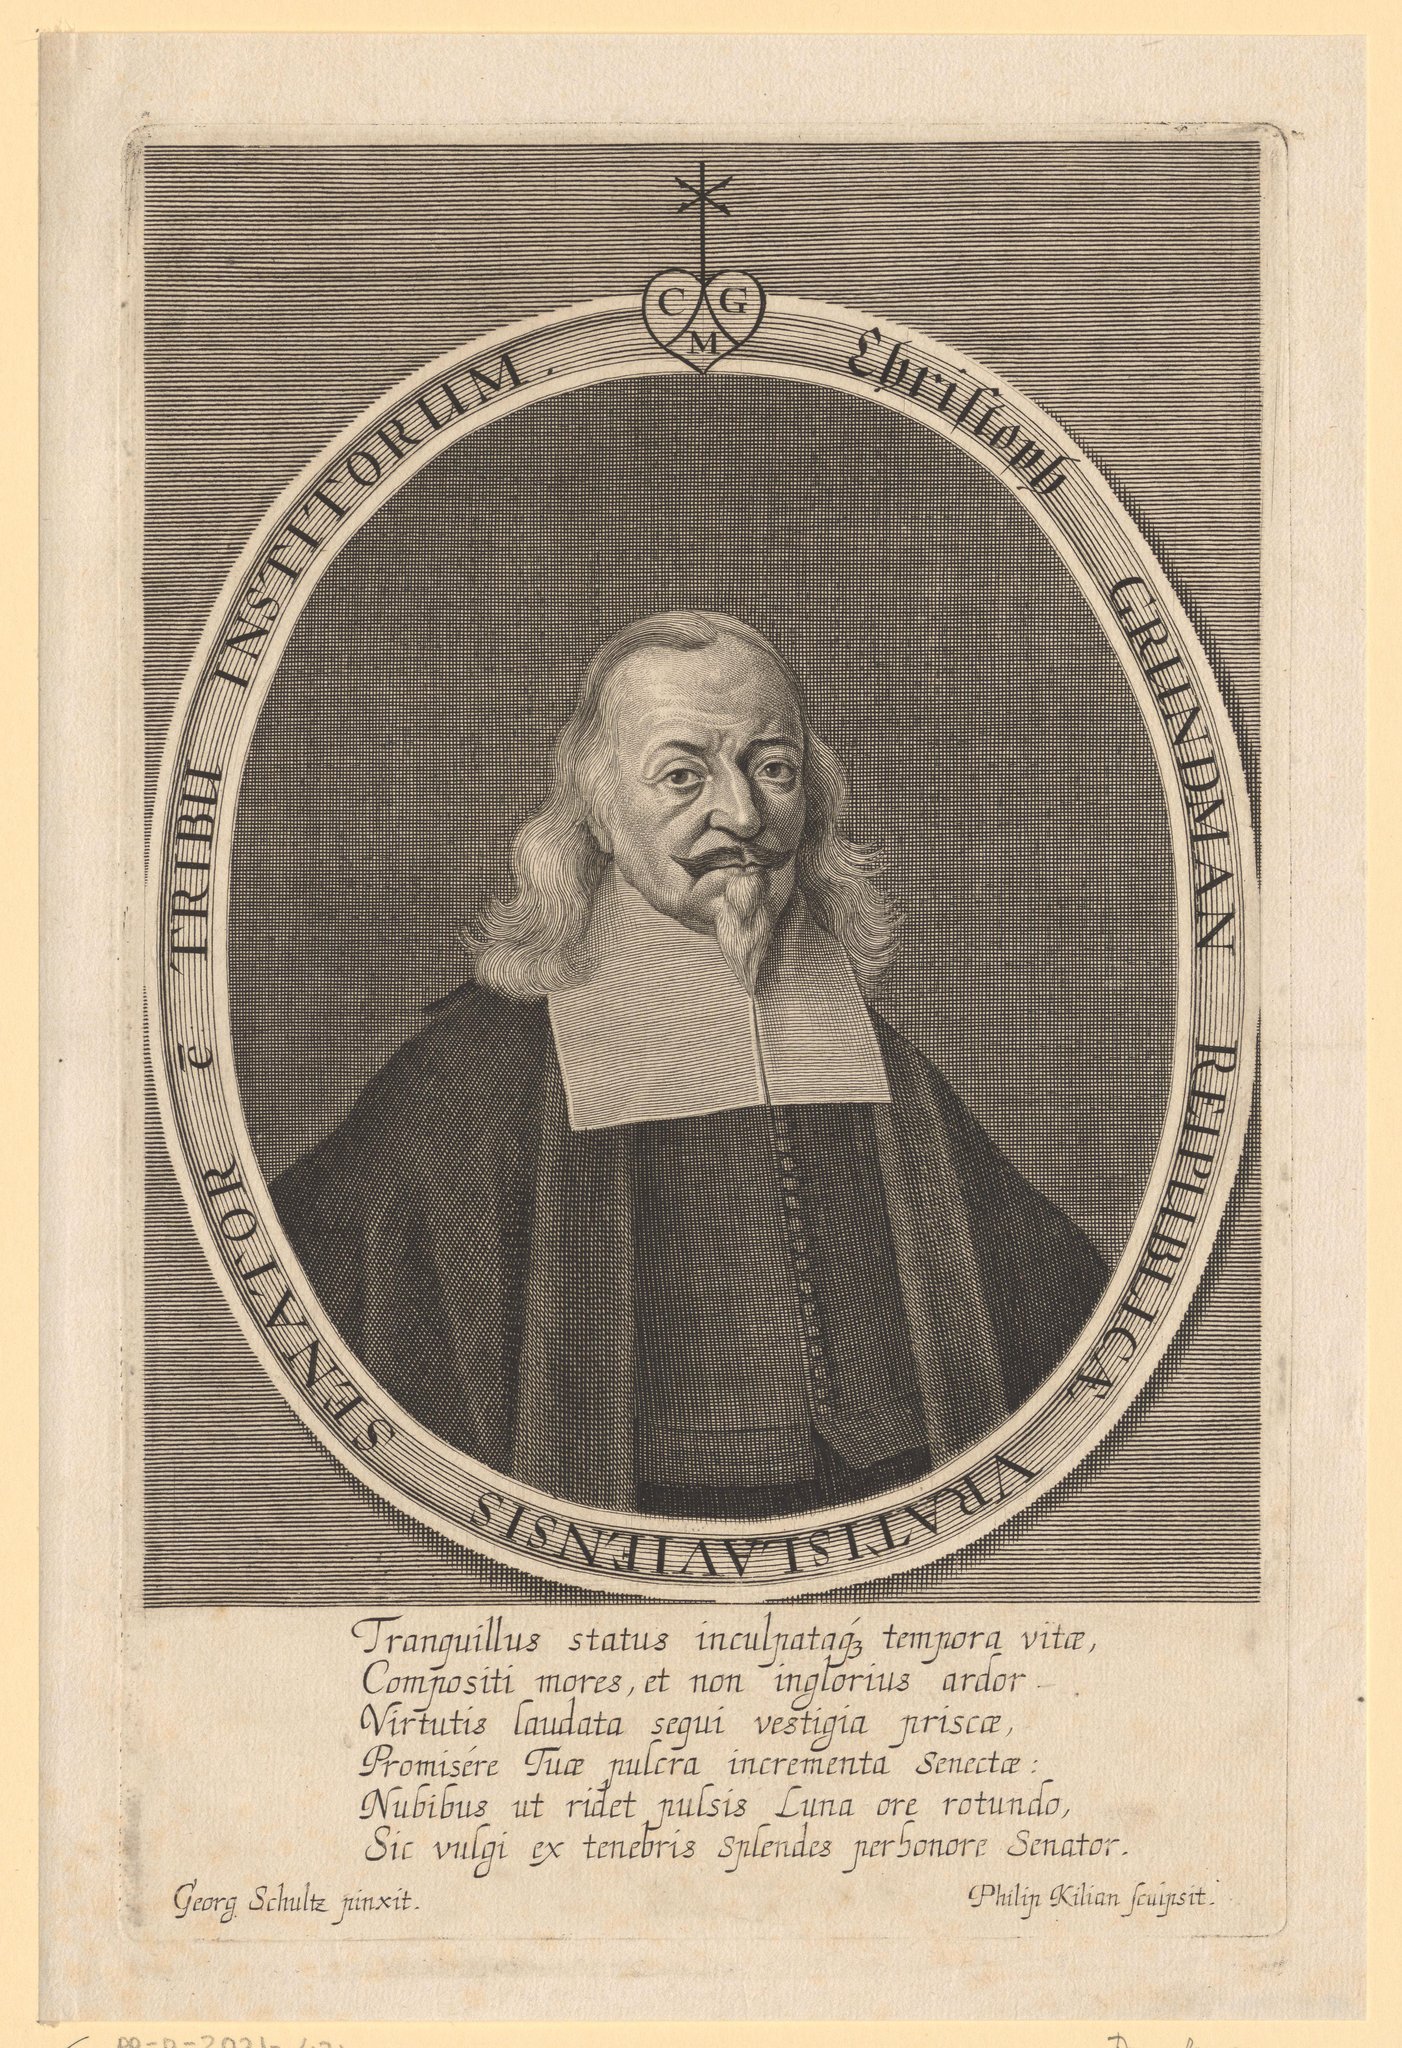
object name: print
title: Portret van Christoph Grundmann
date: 1638-1693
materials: paper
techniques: engraving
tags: city council, historical persons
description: Tekst in het Latijn in de ondermarge en in de omlijsting.